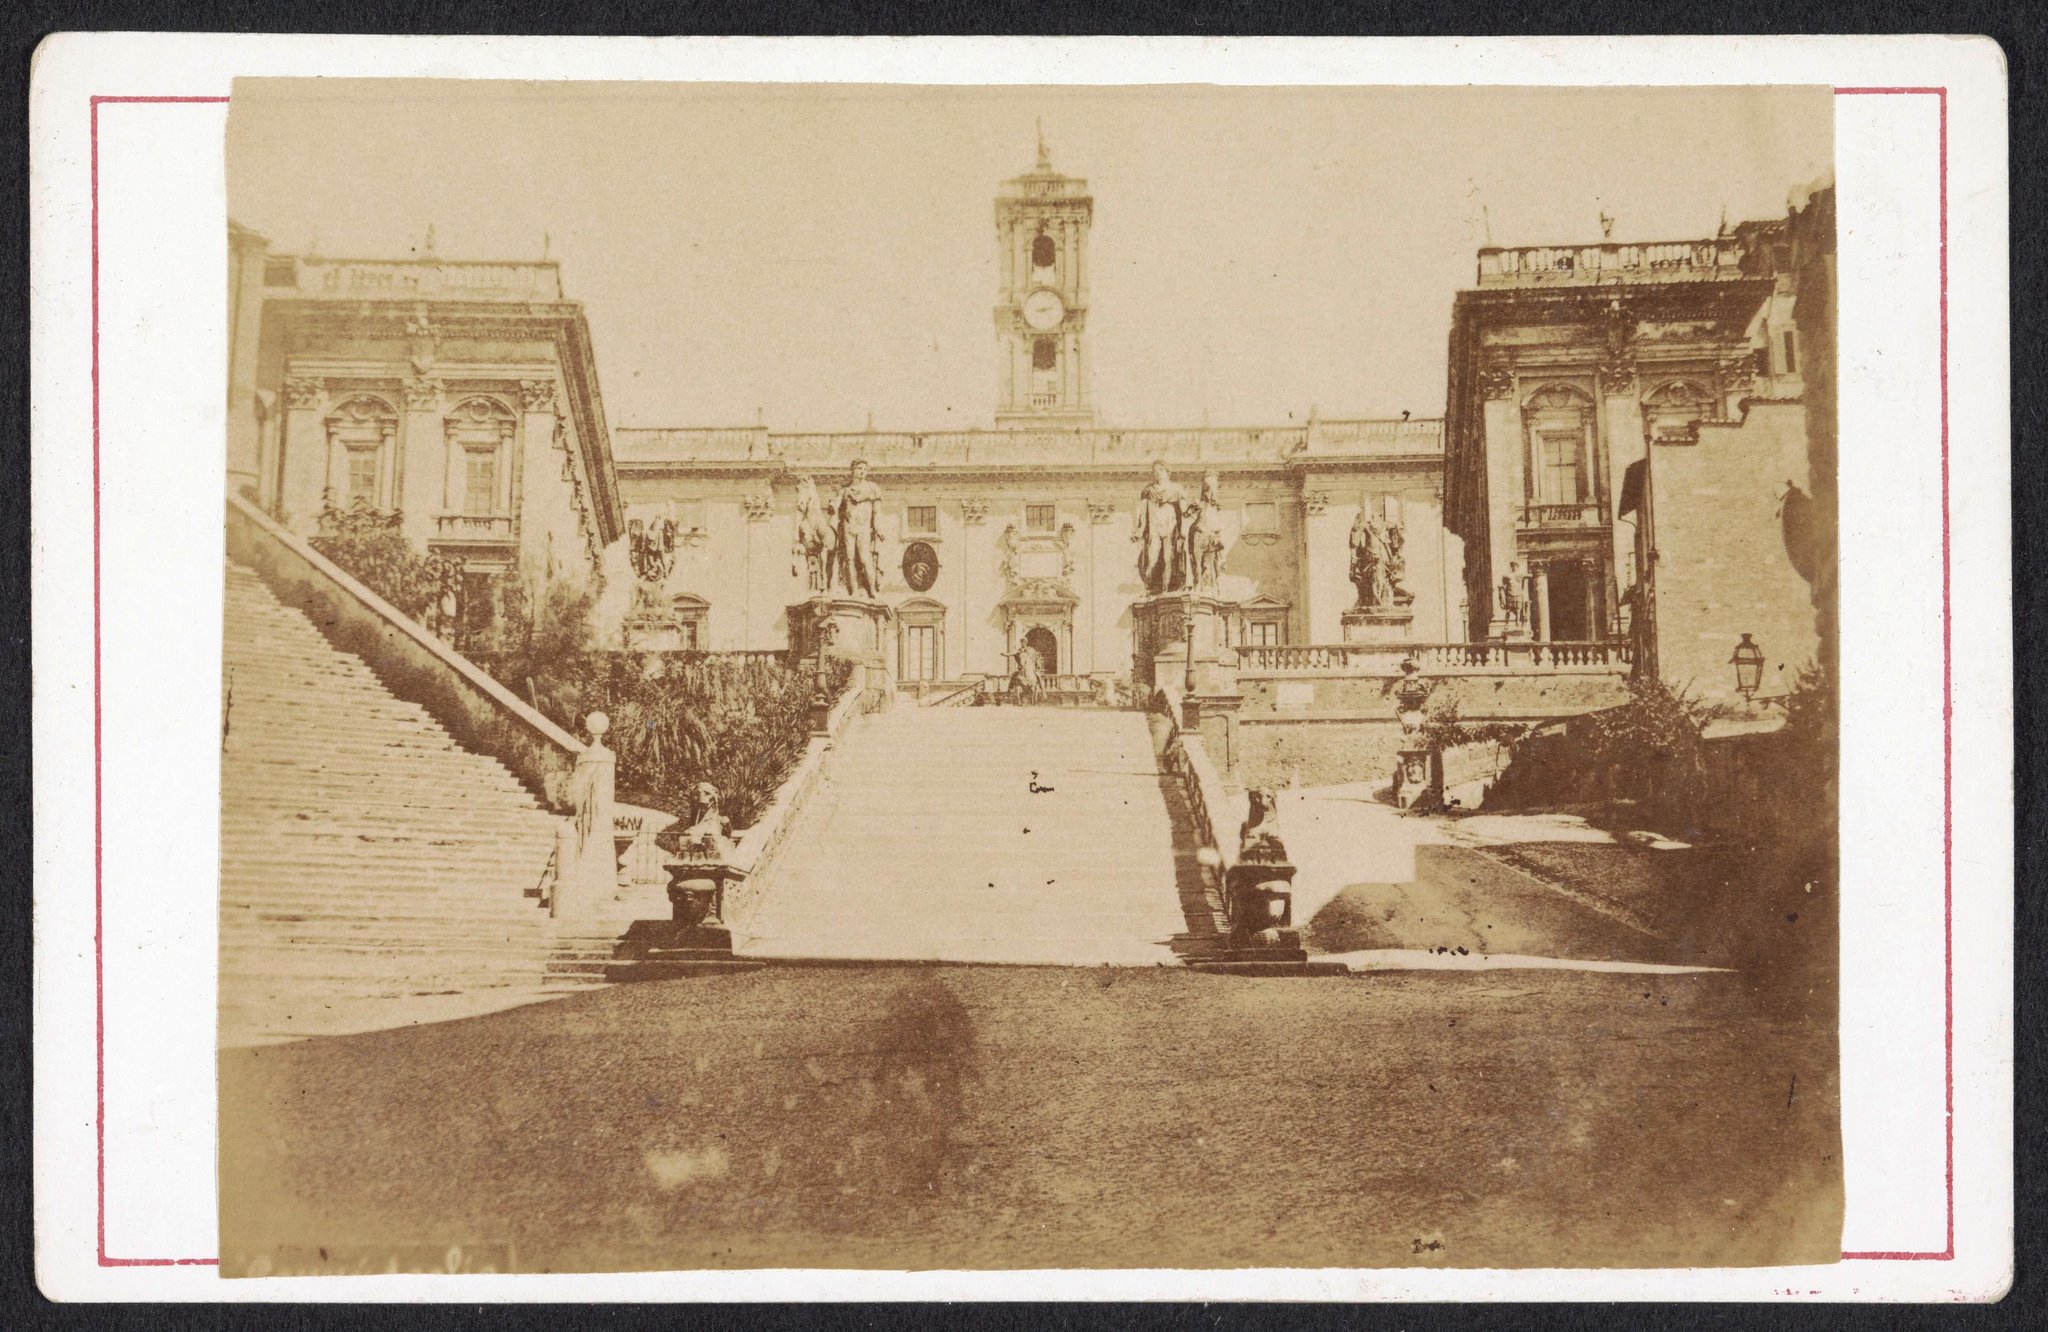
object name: cabinet photograph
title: Gezicht op het Palazzo Senatorio in Rome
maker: Anonymous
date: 1850-1900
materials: cardboard, photographic support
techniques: albumen print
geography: piazza del campidoglio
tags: townhall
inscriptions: annotation: ‘Campidoglio/ Roma’